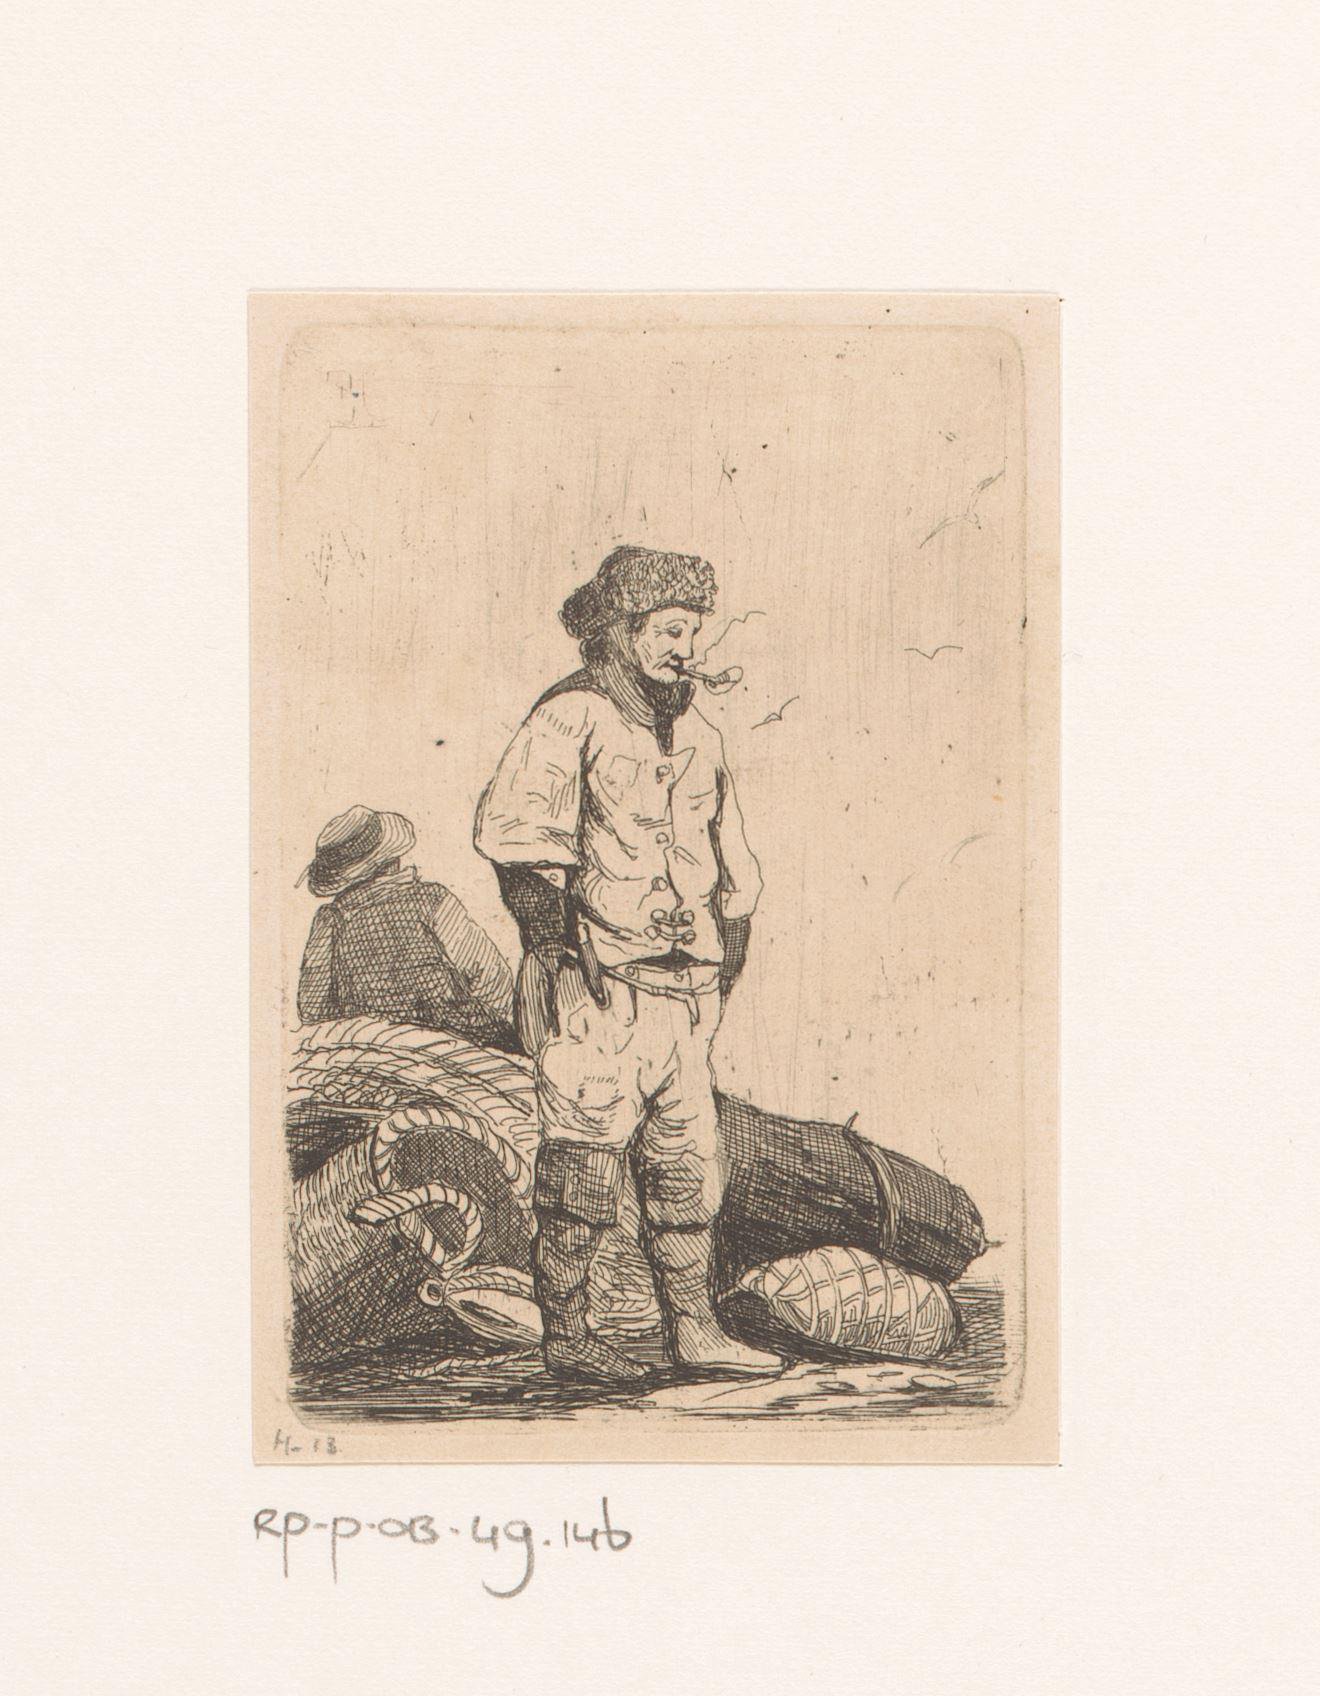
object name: print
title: Visser uit Blankenberge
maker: egidius linnig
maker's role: draughtsman, print maker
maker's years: 1821-1860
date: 1841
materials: paper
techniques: etching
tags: fisherman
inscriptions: collector's mark: Lugt 2228